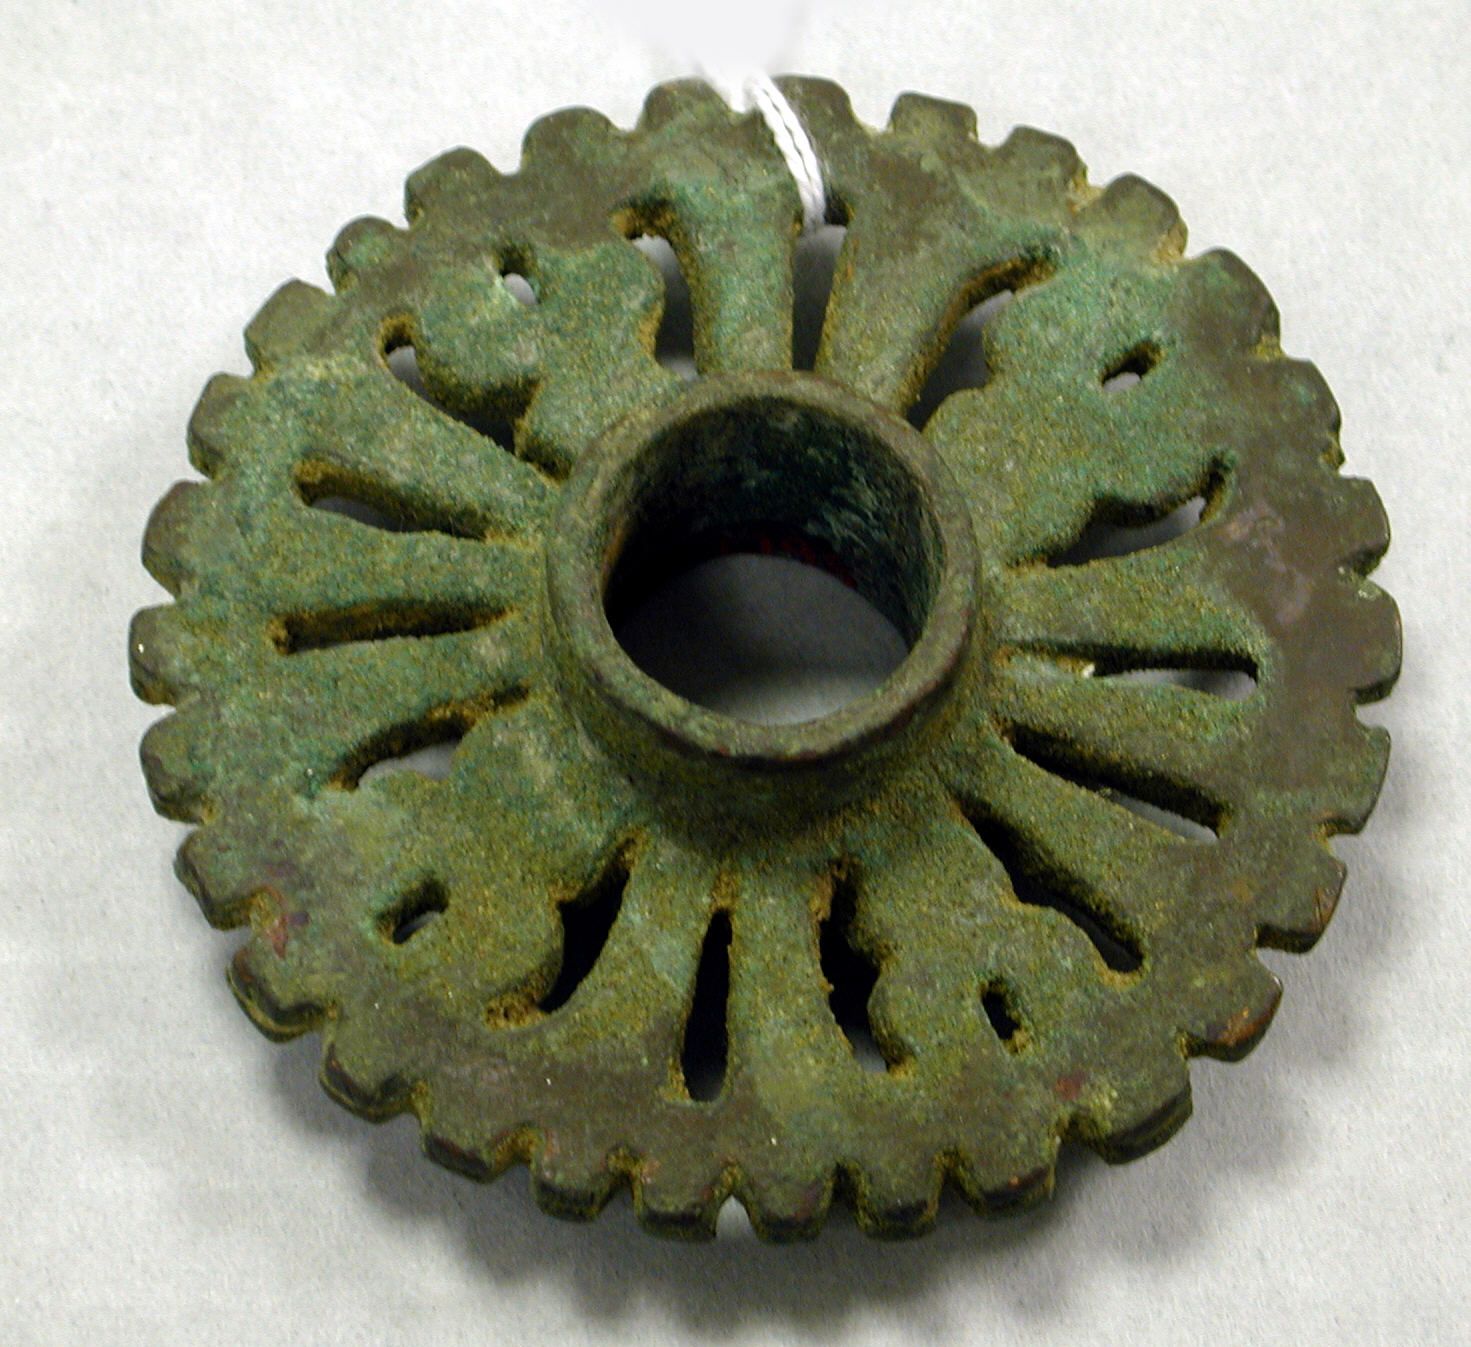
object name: mace head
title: Copper Openwork Mace Head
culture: vicús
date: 300 BCE-200 CE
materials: copper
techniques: casting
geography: peru